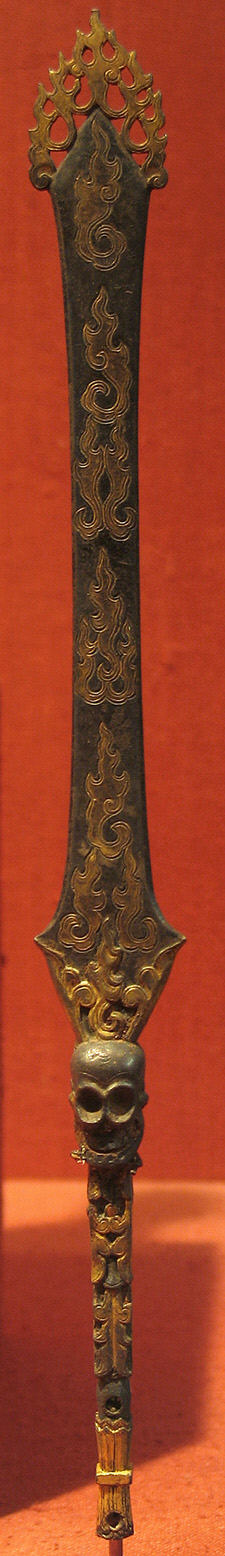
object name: ritual sword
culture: tibetan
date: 1501-1700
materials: silver gilt, gold, iron